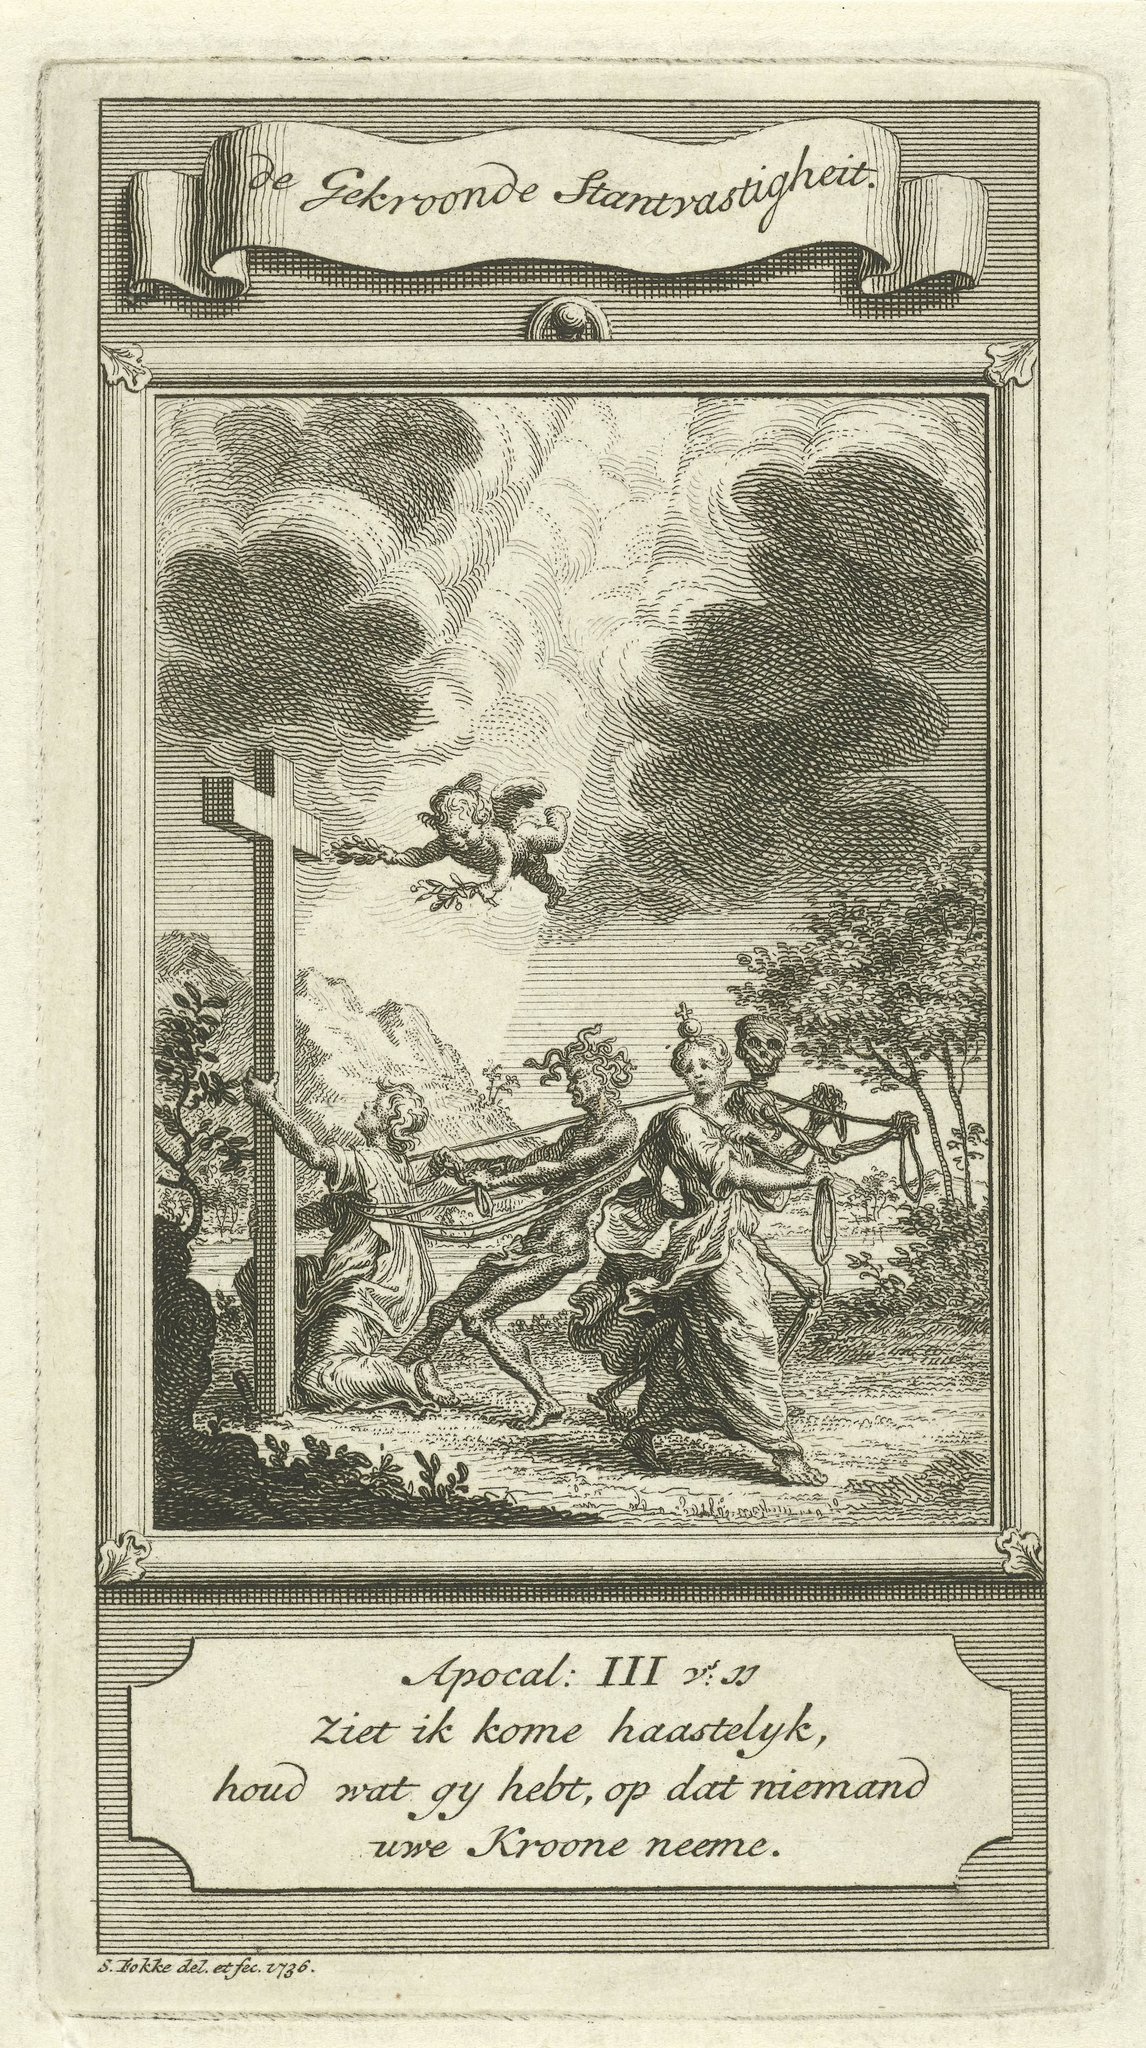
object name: print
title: Allegorie op de standvastigheid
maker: simon fokke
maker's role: draughtsman, print maker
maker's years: 1712-1784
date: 1736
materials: paper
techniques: etching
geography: amsterdam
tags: snakes, death as skeleton, the cross ~ symbols of christ, orb (symbol of sovereignty; sphere with cross on top) - bb - female ruler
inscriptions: collector's mark: Lugt 240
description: Een man klemt zich vast aan een kruis en wordt beschenen door een bundel hemellicht. Boven zijn hoofd vliegt een putto met lauwerkrans. Met touwen wordt hij door een skelet, een vrouw met een rijksappel op haar hoofd en een naakte man met slangen als haren van het kruis weggetrokken. Boven de voorstelling staat op een banderol de tekst: De Gekroonde Stantvastigheit. Onderaan wordt verwezen naar een bijbelboek.